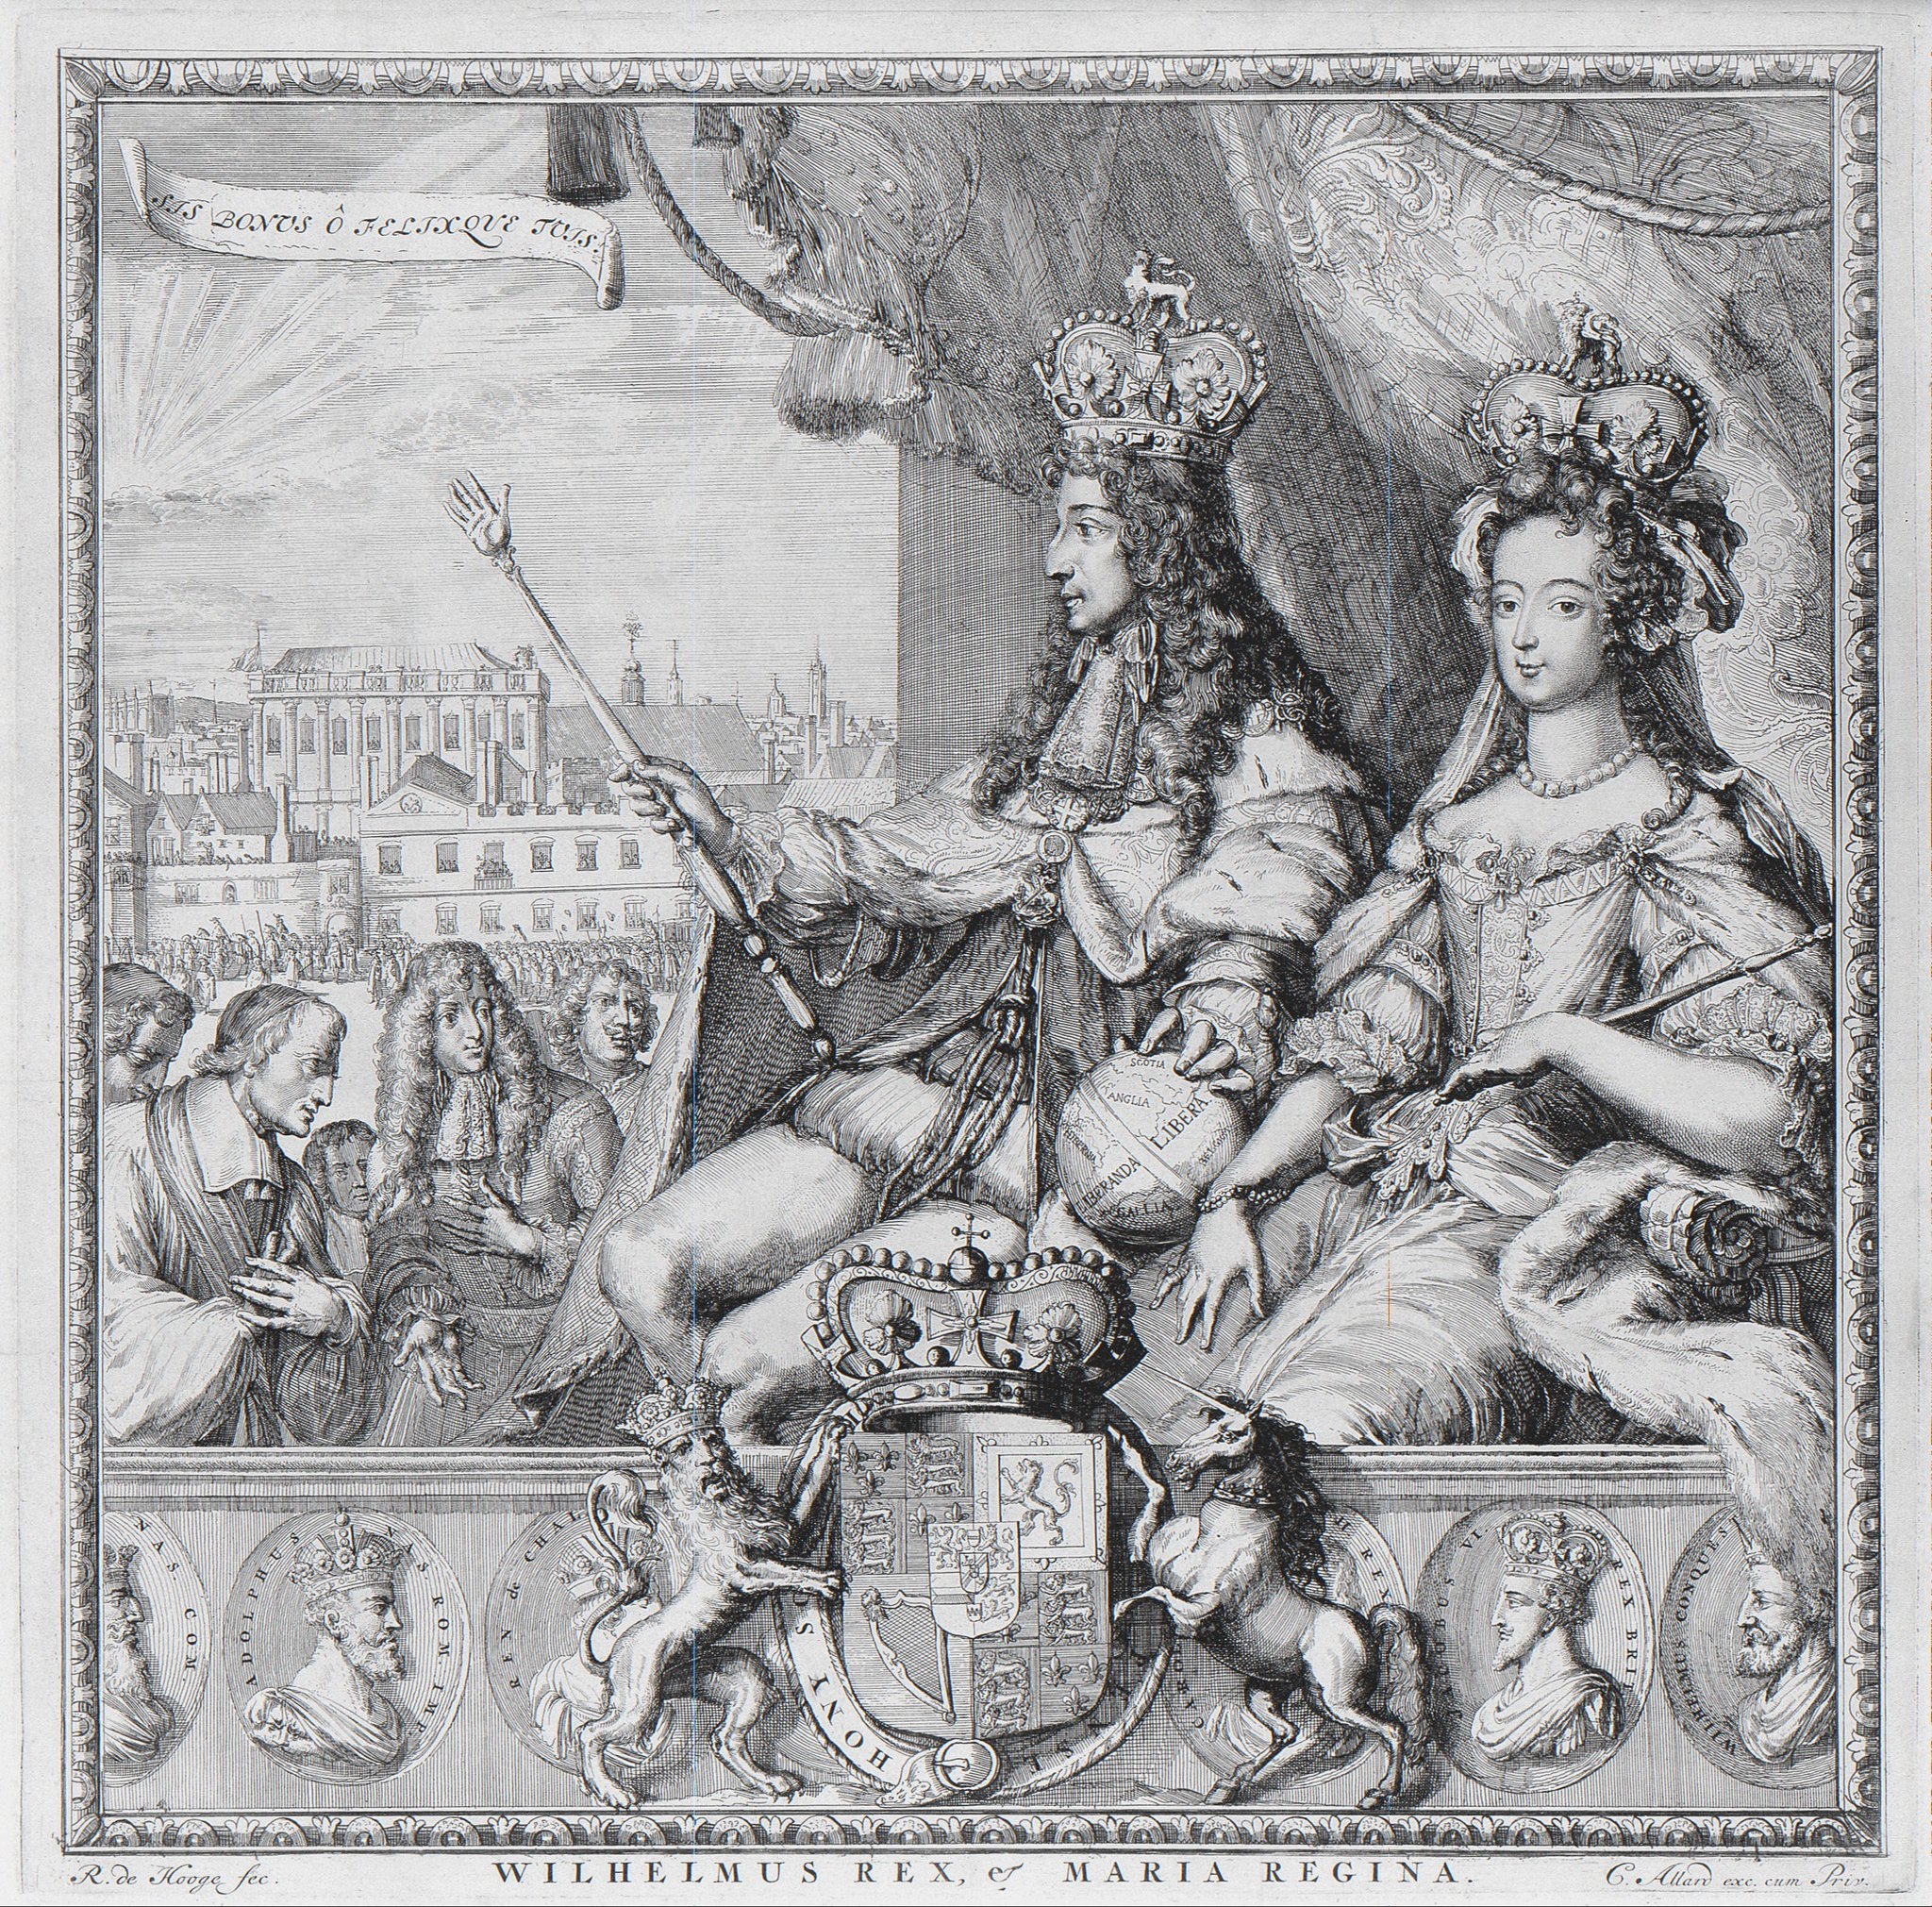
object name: print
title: Allegorie op de kroning van Willem en Mary tot koning en koningin van Groot-Brittannië, 1689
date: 1689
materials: paper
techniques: etching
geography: netherlands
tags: the hague, william iii (prince of orange and king of england, scotland, and ireland), maria ii stuart (koningin van engeland, schotland en ierland), coronation of a ruler, homage to a ruler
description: Allegorie op de kroning van Willem en Maria als koning en koningin van Groot-Brittannië, 21 april 1689. Het echtpaar zittend voor een gedrapeerd gordijn, scepters in de hand. Links enkele toeschouwers, op de achtergrond het paleis van Whitehall te Londen. Onderaan het wapen van Groot-Brittannië en medaillons met portretten van eerdere Engelse koningen.